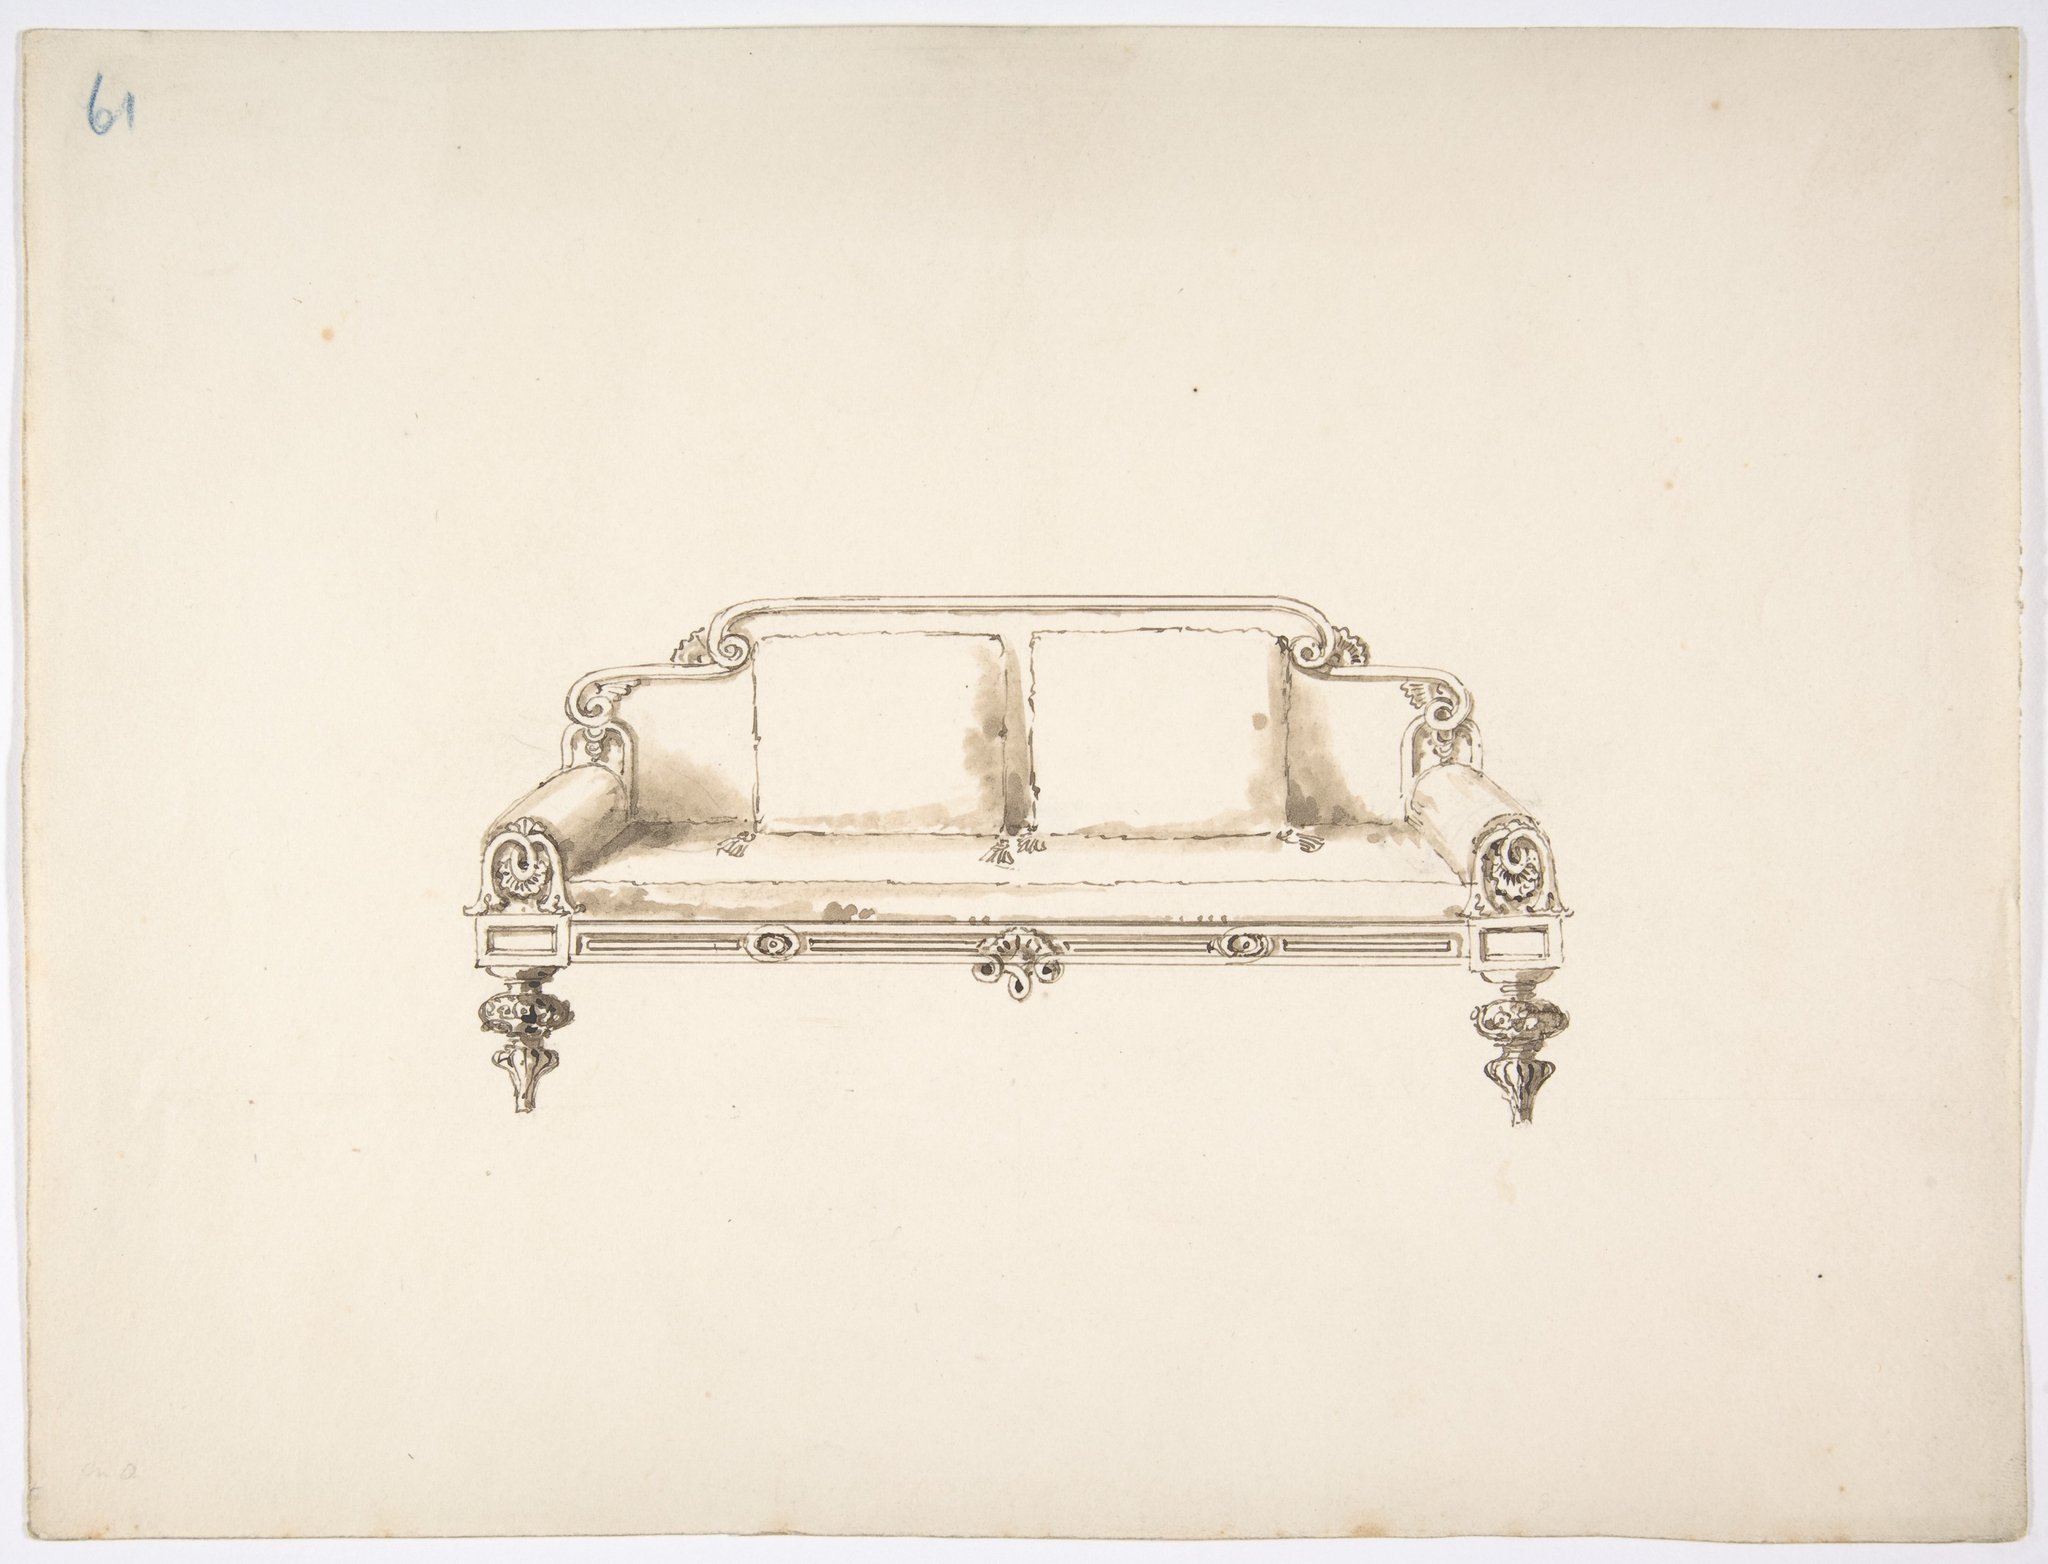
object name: drawing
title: Design for a Sofa with Two Loose Cushions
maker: anonymous, british, 19th century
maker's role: artist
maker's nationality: british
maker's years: 1800-1900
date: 1801-1833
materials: ink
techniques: brush, pen, wash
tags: couches